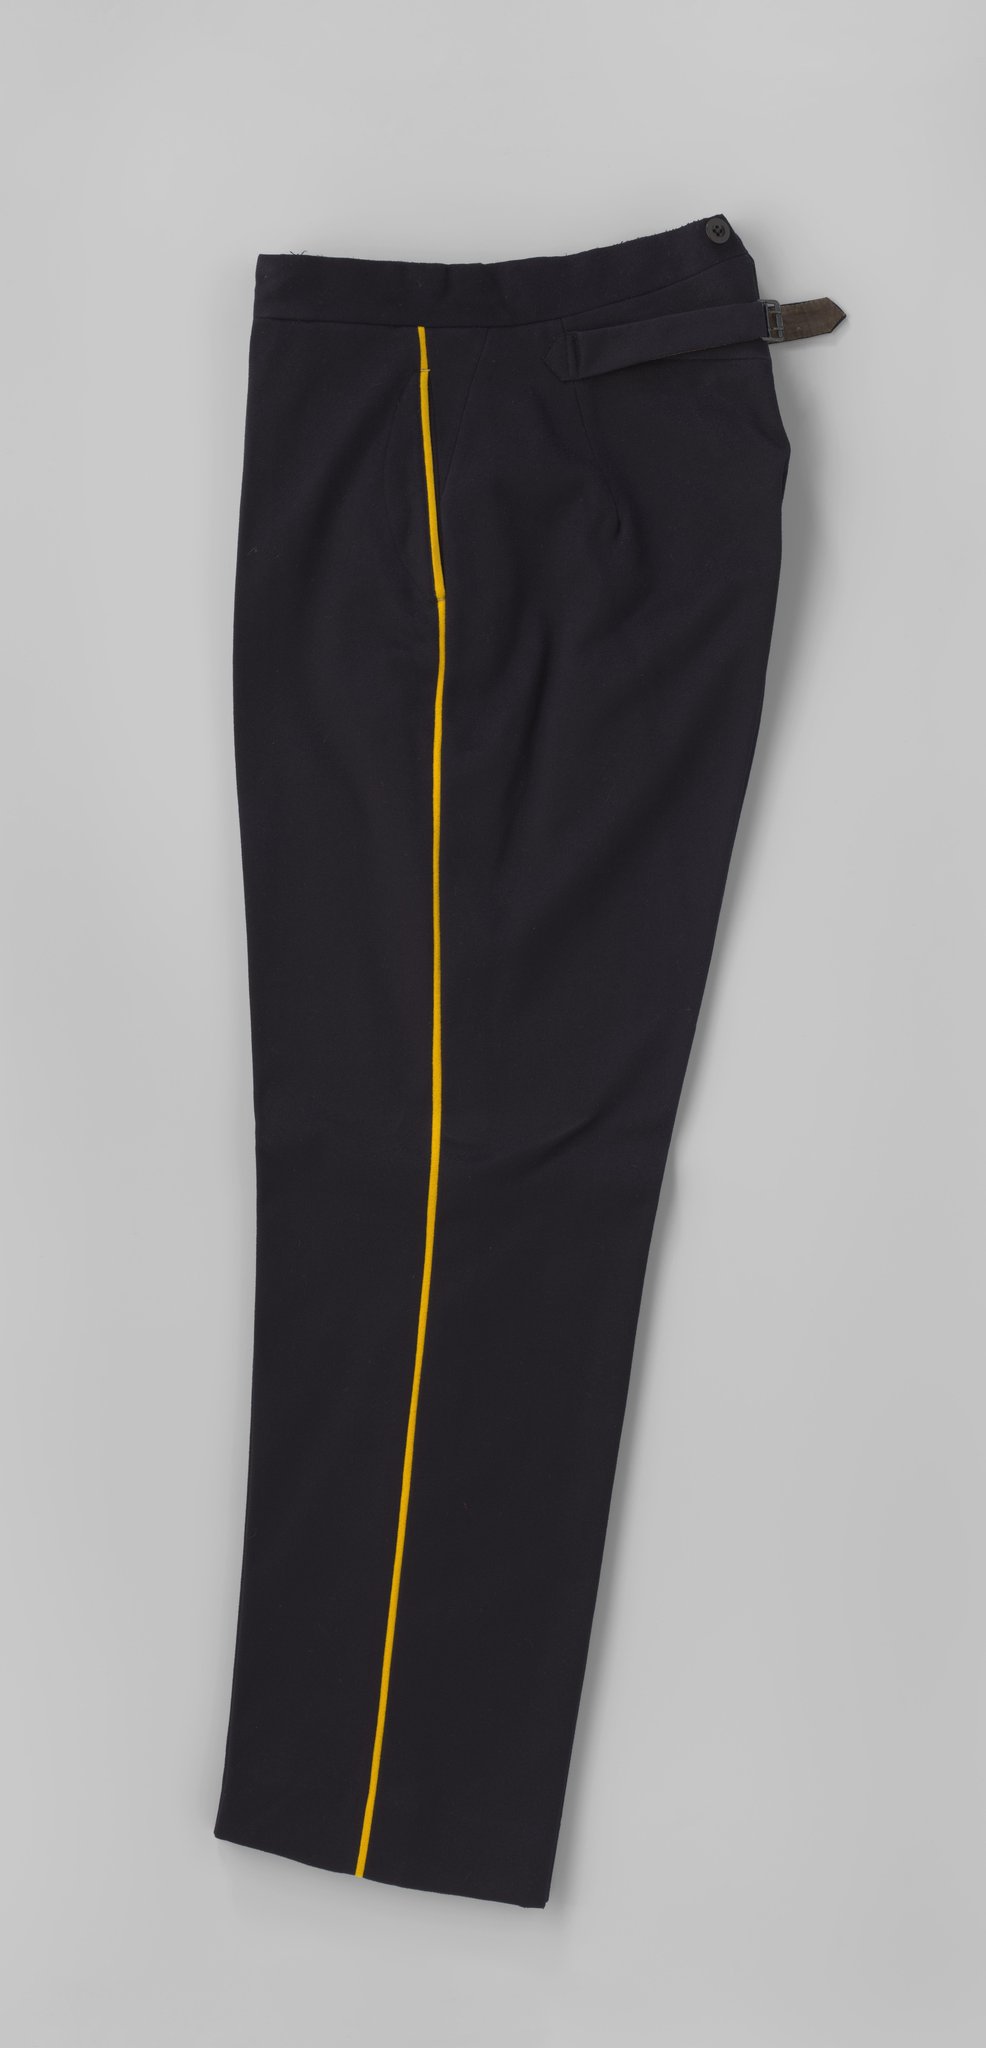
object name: pant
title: Zwarte broek met gele bies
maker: Anonymous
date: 1900-1960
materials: textile, plastic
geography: netherlands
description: Zwarte broek met gele bies en zwarte kunststof knopen, aan de binnenzijde wit gevoerd.